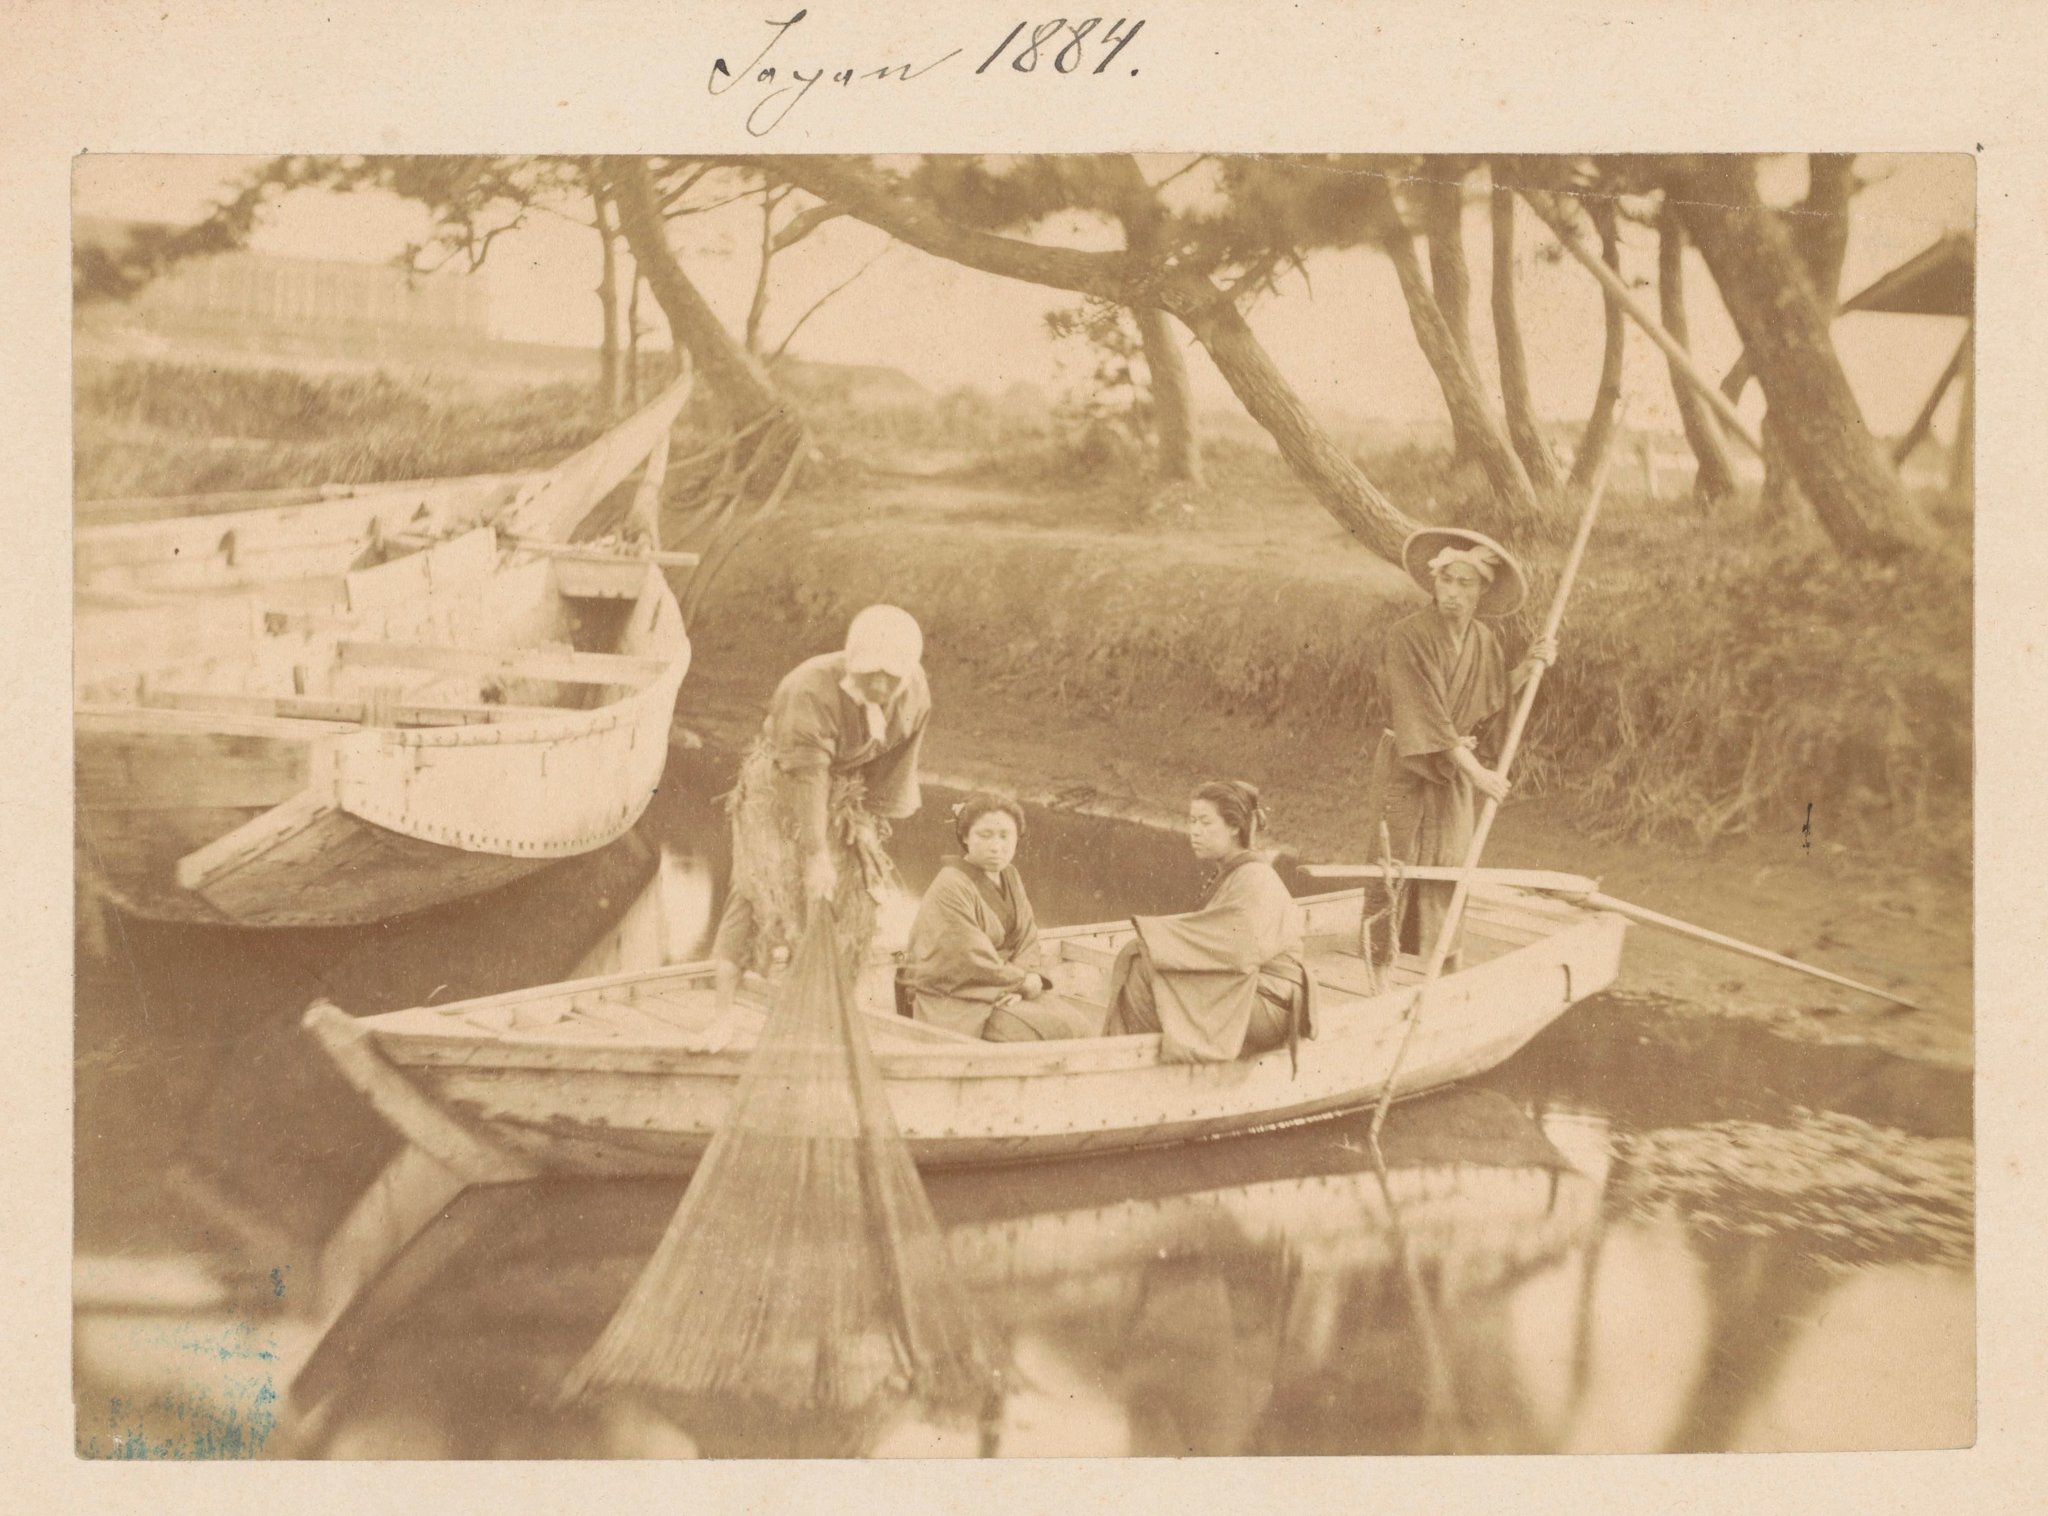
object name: photograph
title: Japan 1884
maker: Anonymous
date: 1884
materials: cardboard, paper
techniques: albumen print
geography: japan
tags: rowing-boat, canoe, etc., fisherman, japan